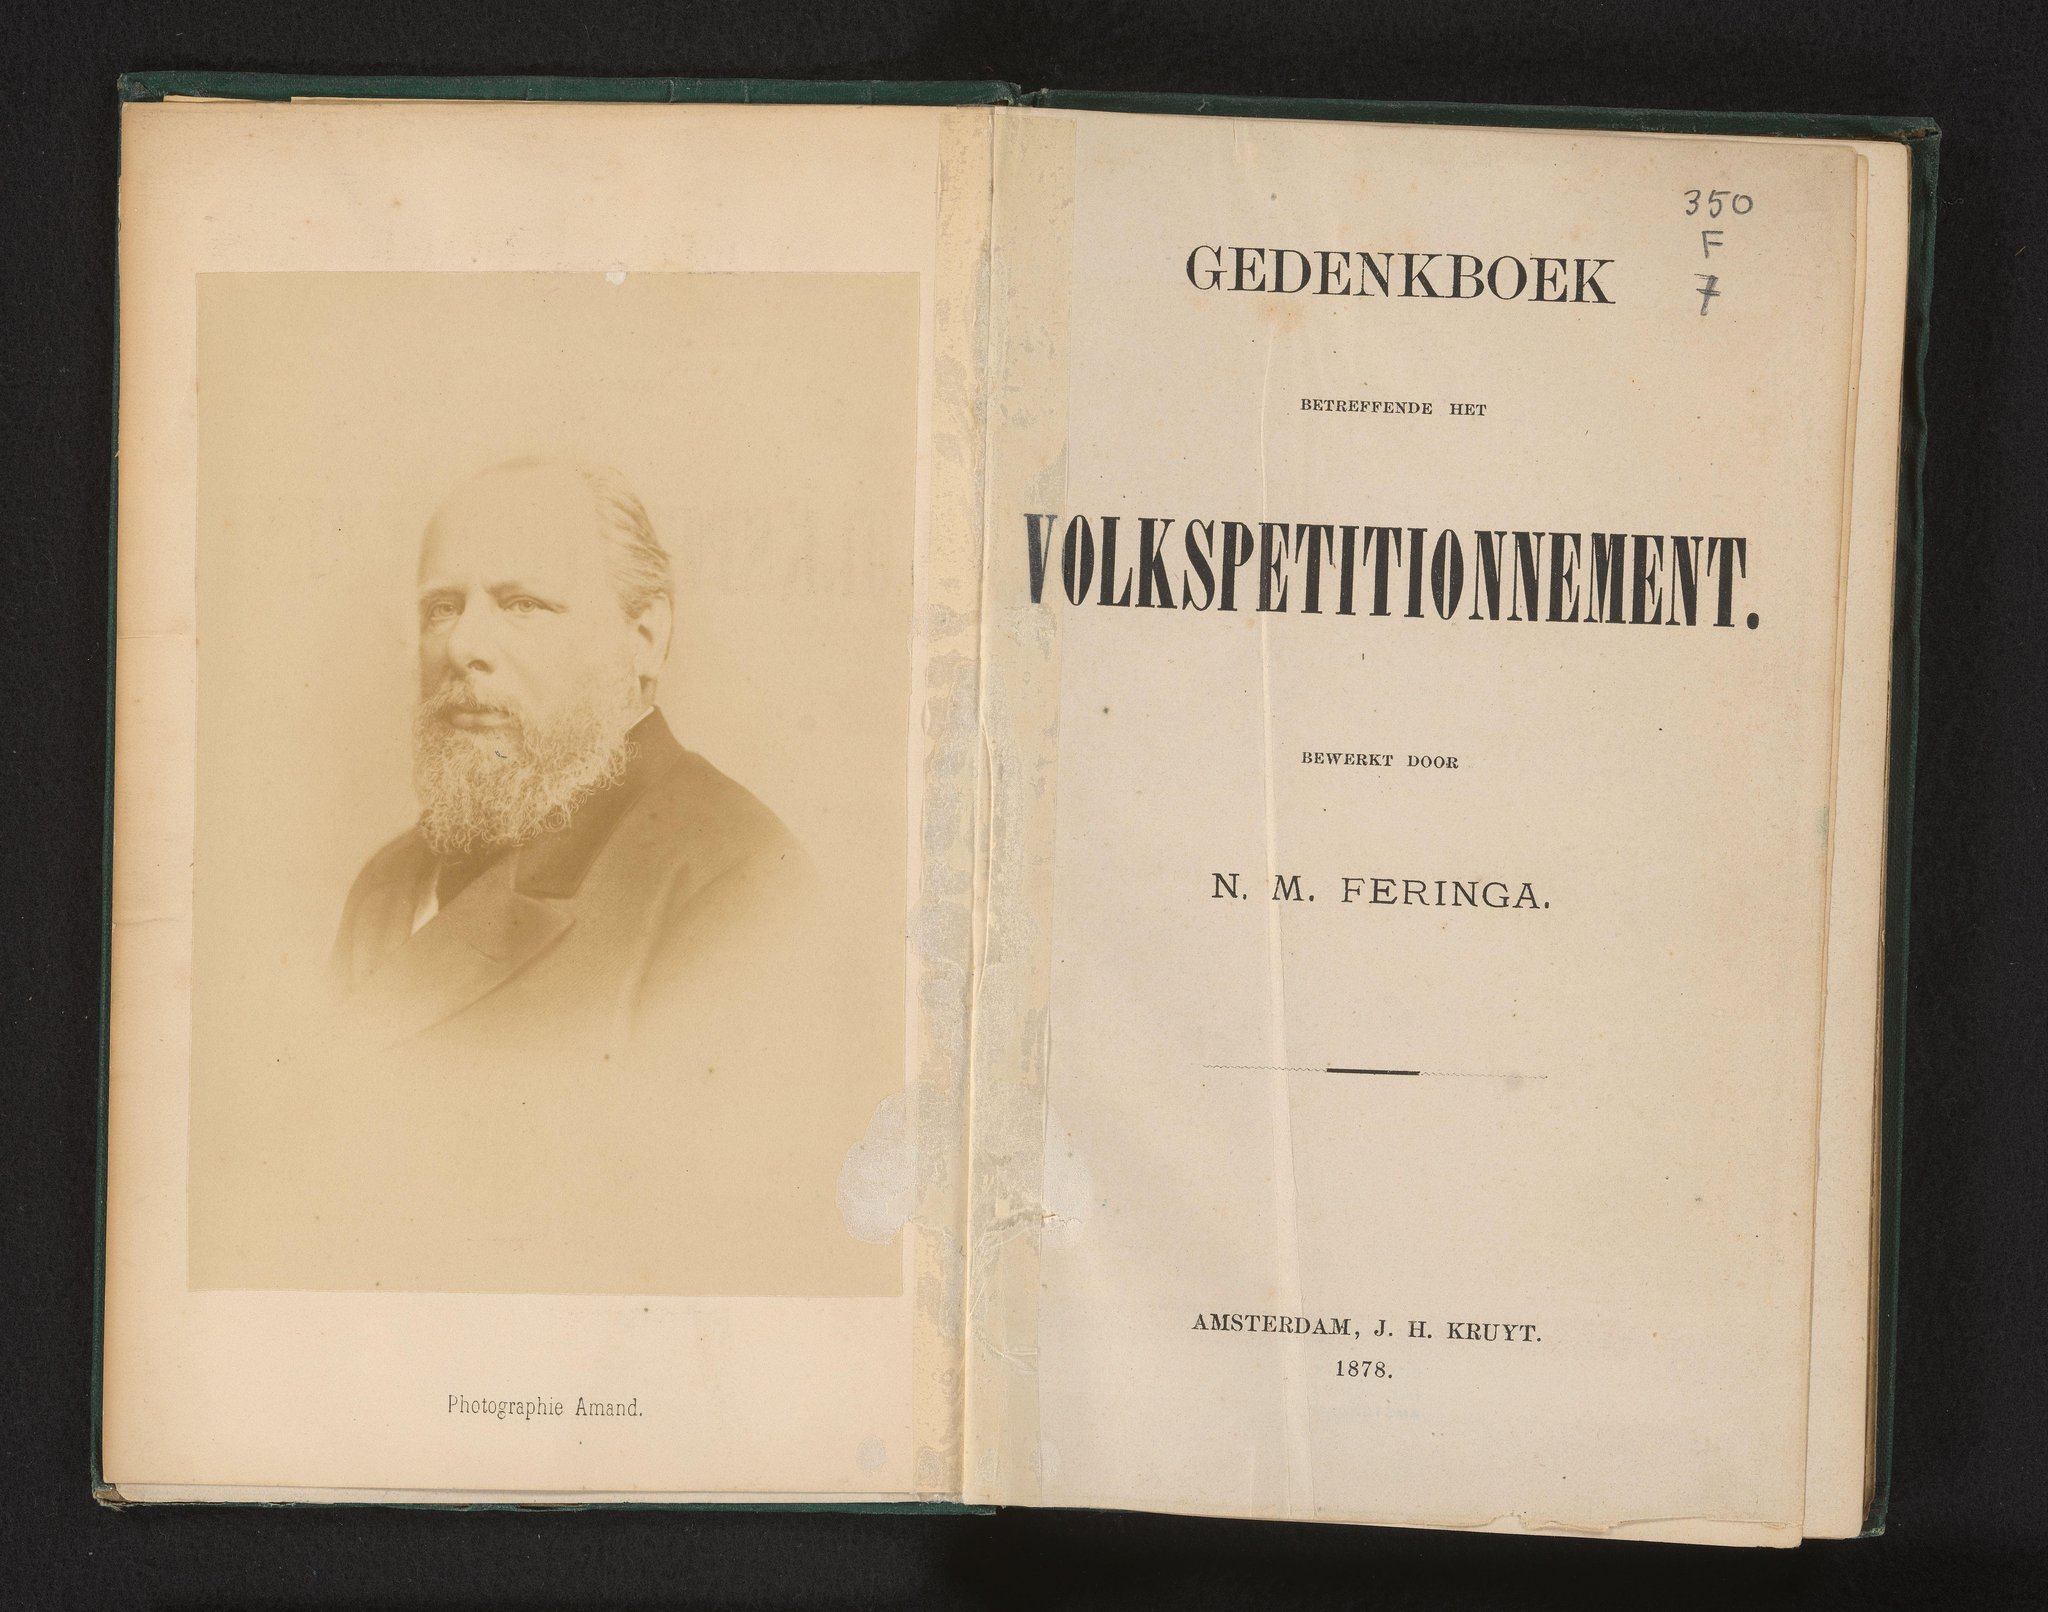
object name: photograph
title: Portret van koning Willem III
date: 1873-1878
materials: paper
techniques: albumen print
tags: brussels, willem iii (koning der nederlanden), historical persons, king